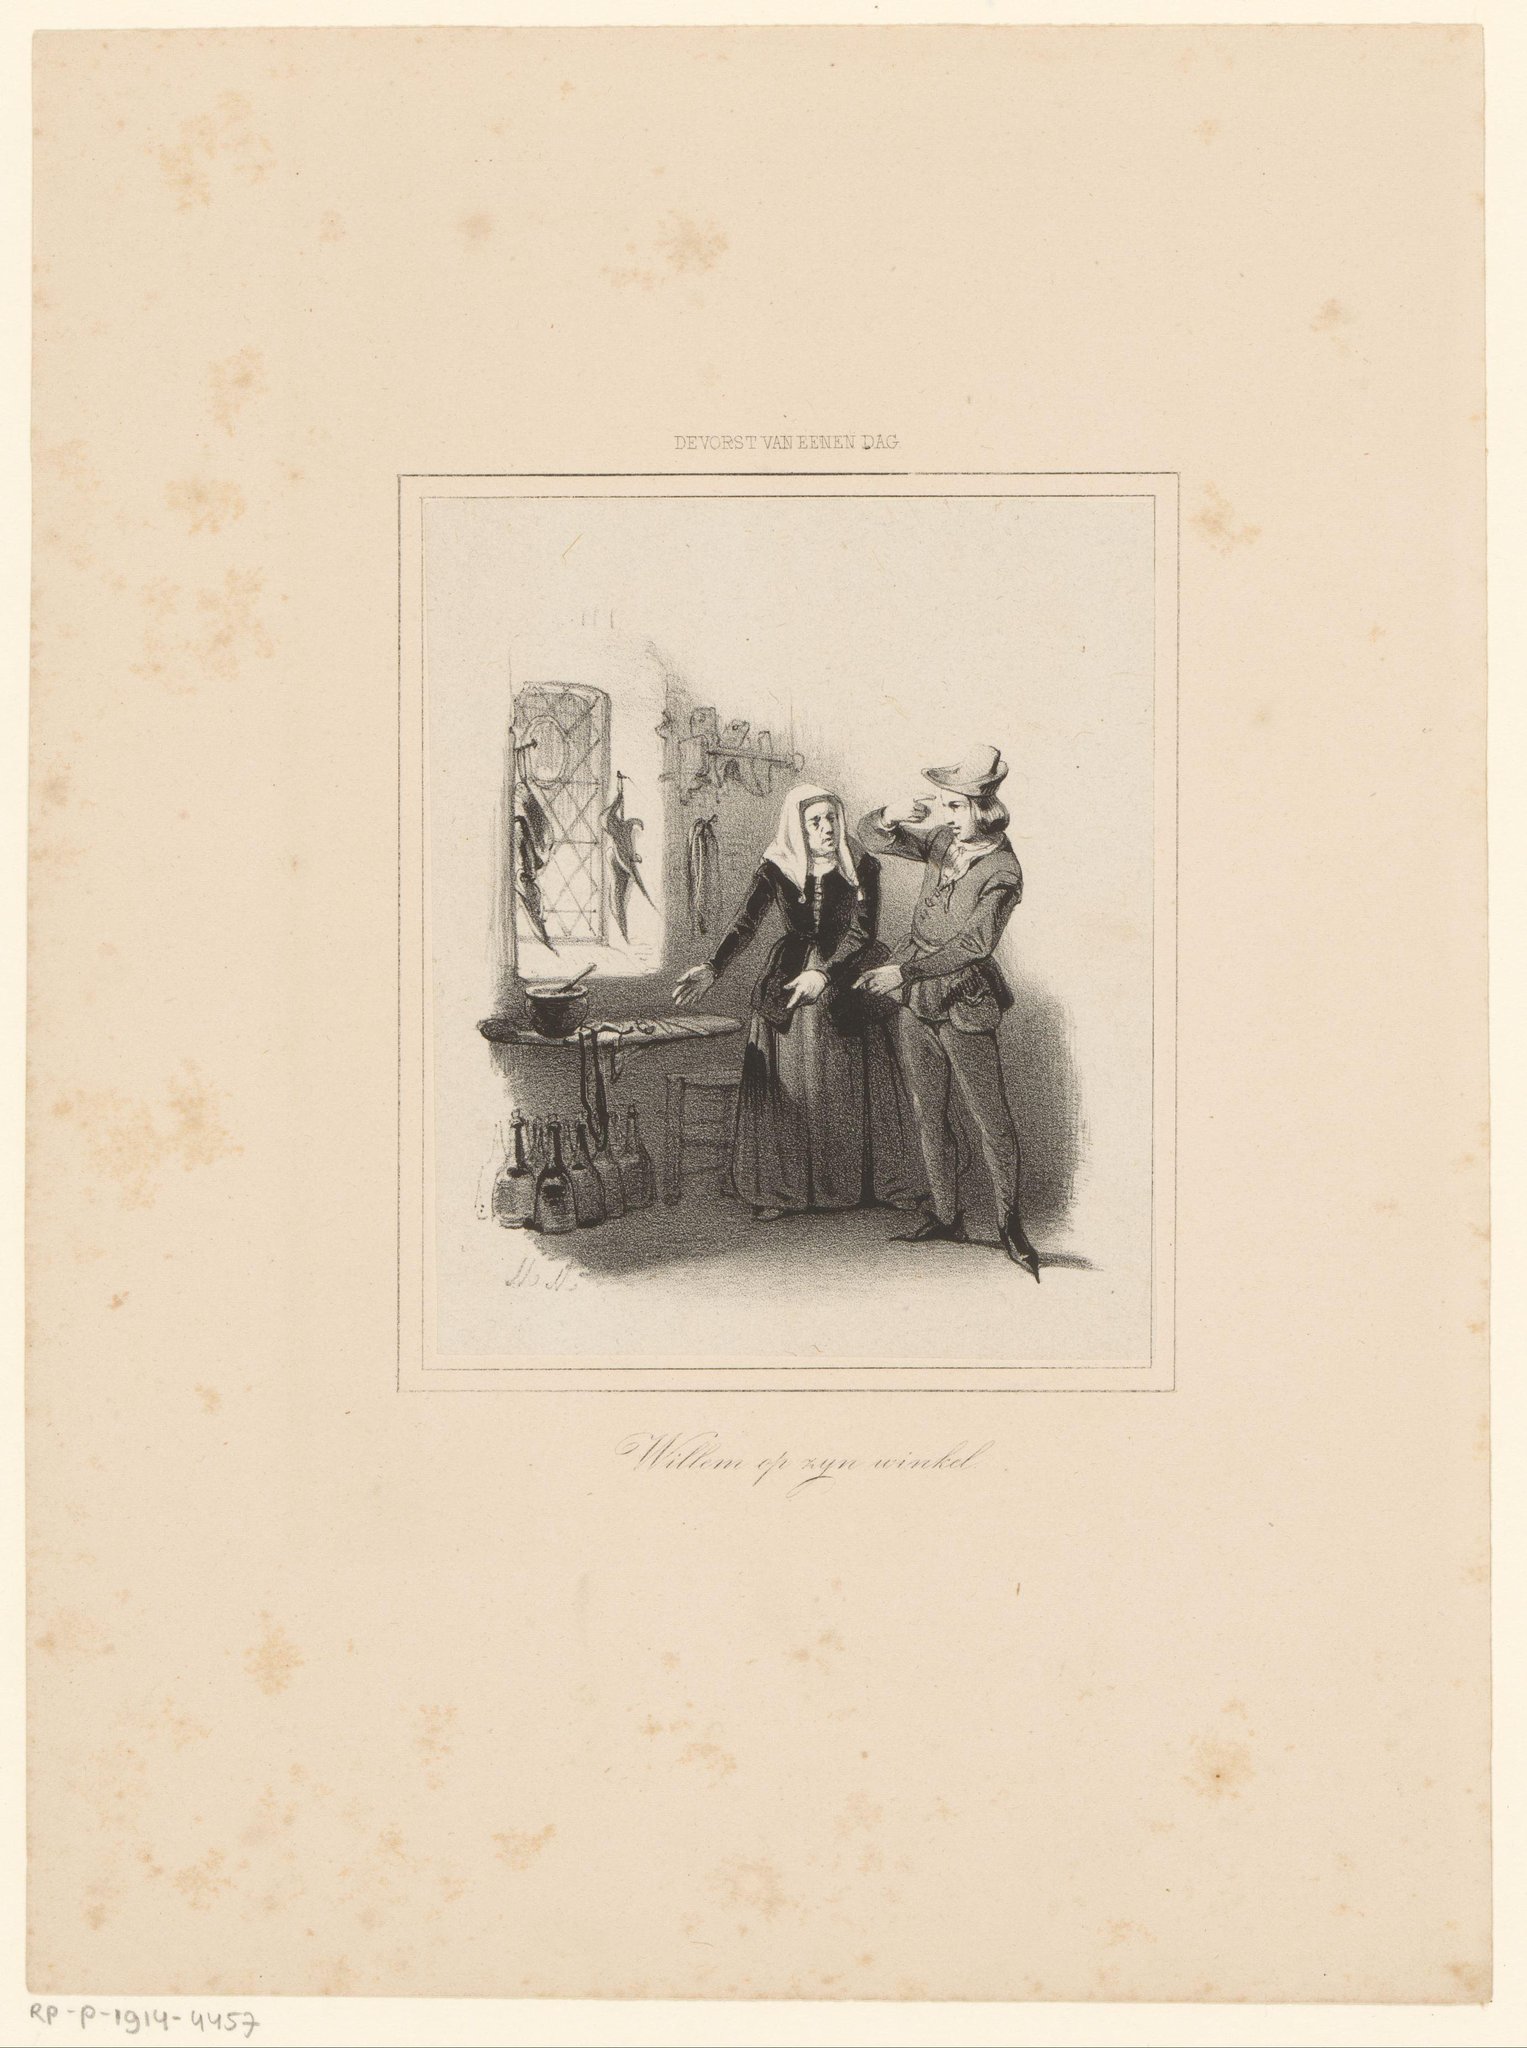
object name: print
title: De vorst van eenen dag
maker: michel mourot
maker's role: draughtsman, print maker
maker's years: 1803-1847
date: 1842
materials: paper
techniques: lithograph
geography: the hague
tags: bruges, philip iii the good, mending, repairing ~ clothes, shoes, sandals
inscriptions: collector's mark: Lugt 2228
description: Filips de Goede treft Willem van Nieuwen, een schoenmaker, dronken aan in het bos. Hij besluit een grap met hem uit te halen door hem mee te nemen naar het paleis om hem daar zijn roes uit te laten slapen. De hofhouding doen hem geloven dat hij de vorst is. Na het avondmaal valt Willem dronken in slaap en hij wordt teruggebracht naar zijn eigen huis en ontdaan van de vorstelijke kleding. De volgende dag wordt hij wakker in zijn schoenwinkel denkt hij dat hij heeft gedroomd. Dan ziet hij een geschenk van Filips de Goede, een aantal flessen drank.